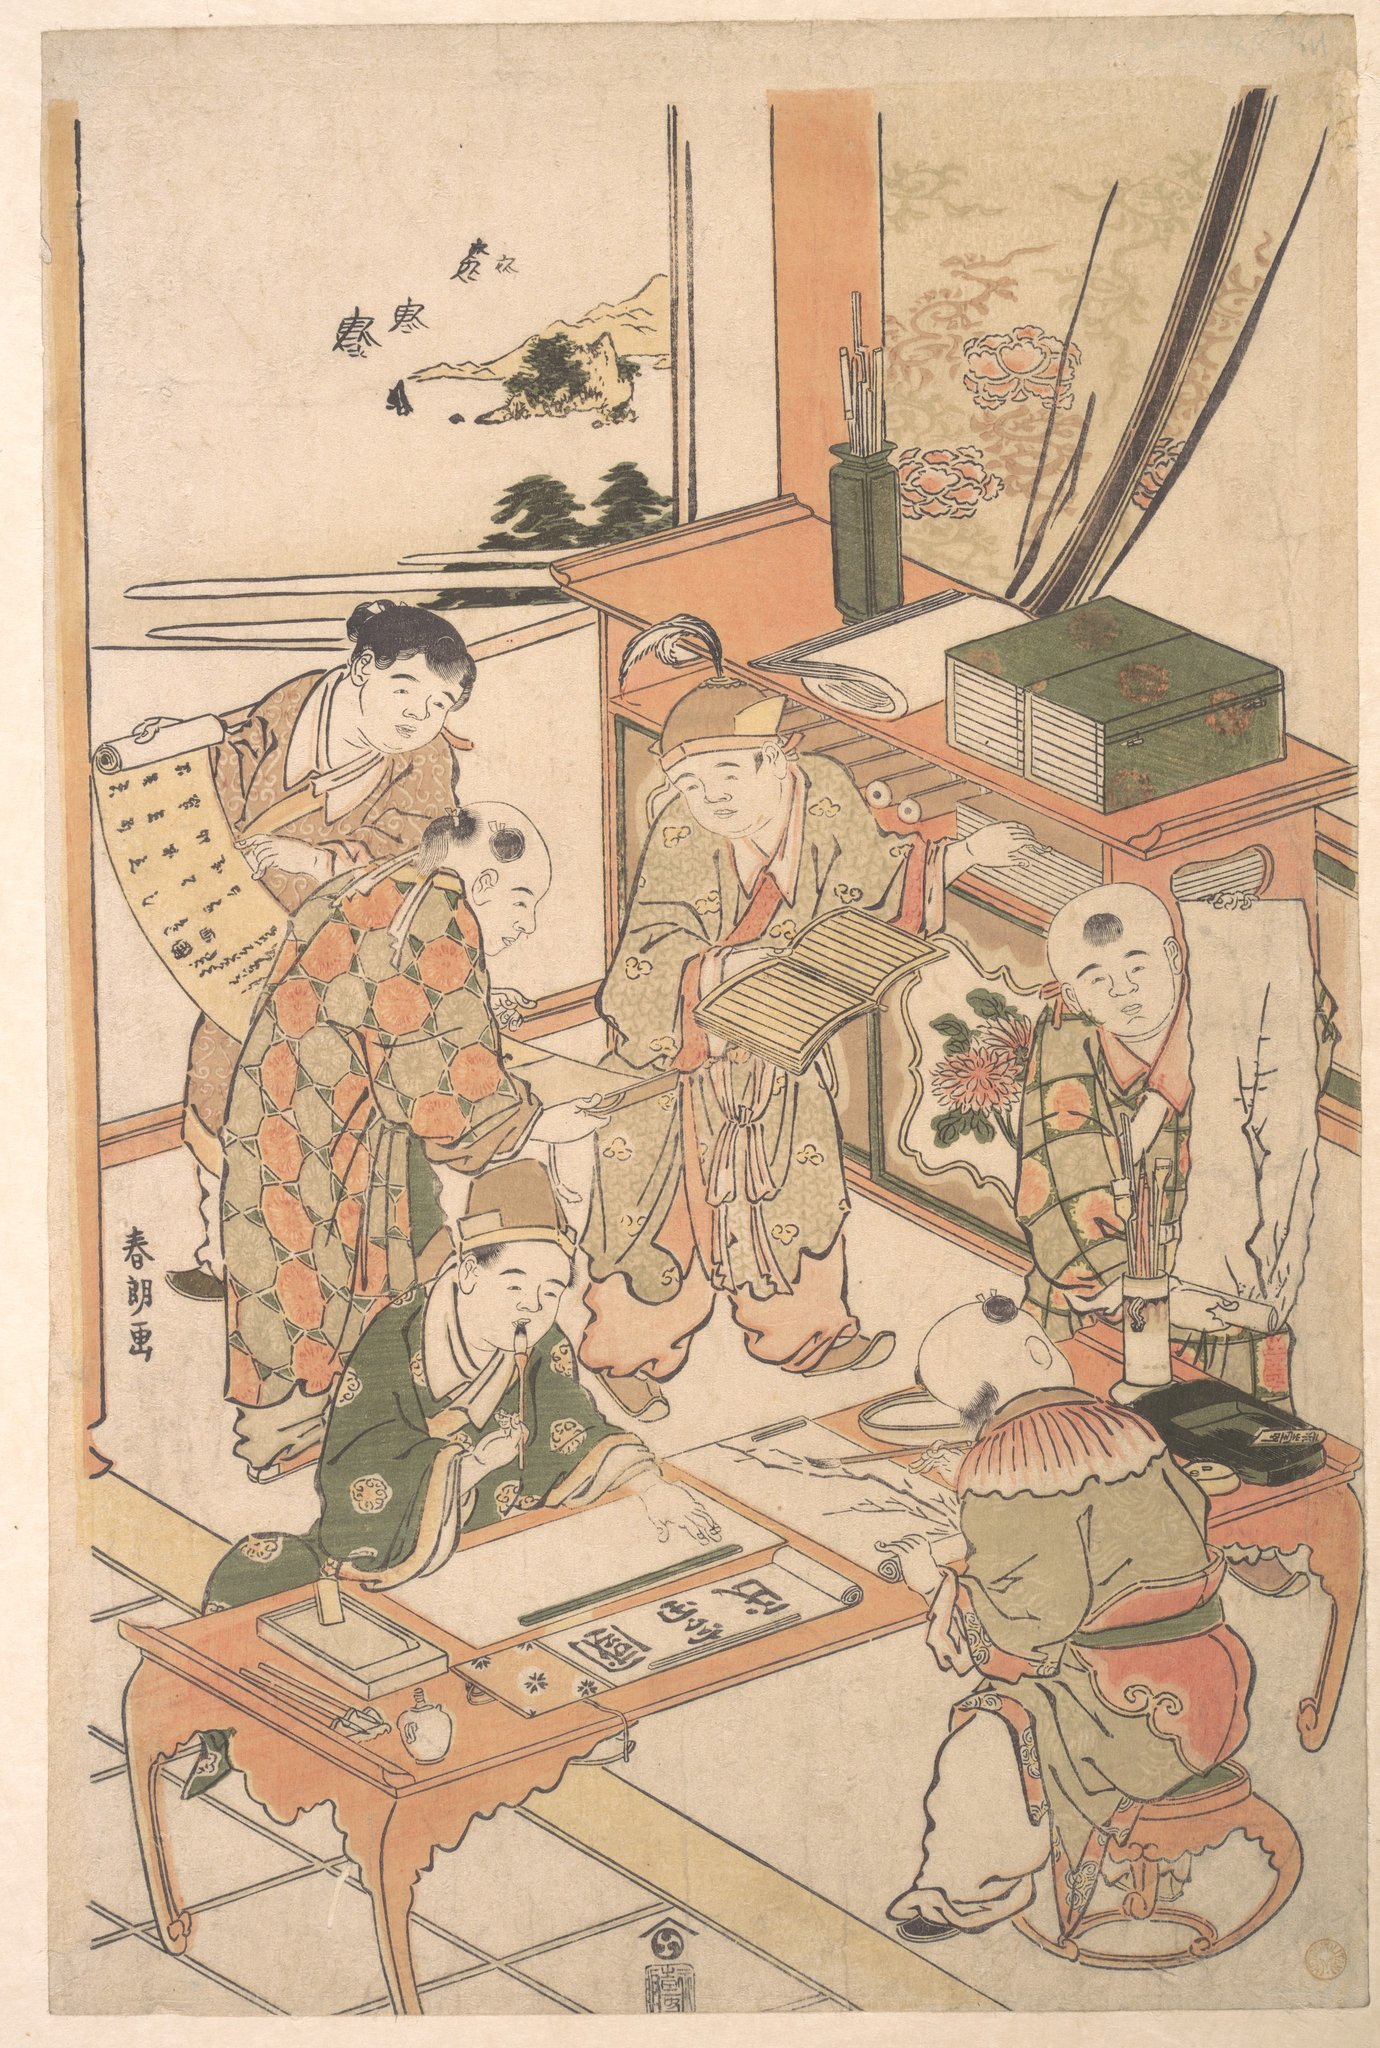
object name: print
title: Chinese Boys Learning to Write and Paint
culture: japanese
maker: katsushika hokusai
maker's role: artist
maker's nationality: japanese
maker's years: 1760-1849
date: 1785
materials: ink, paper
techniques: woodblock print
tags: painting,boys,writing